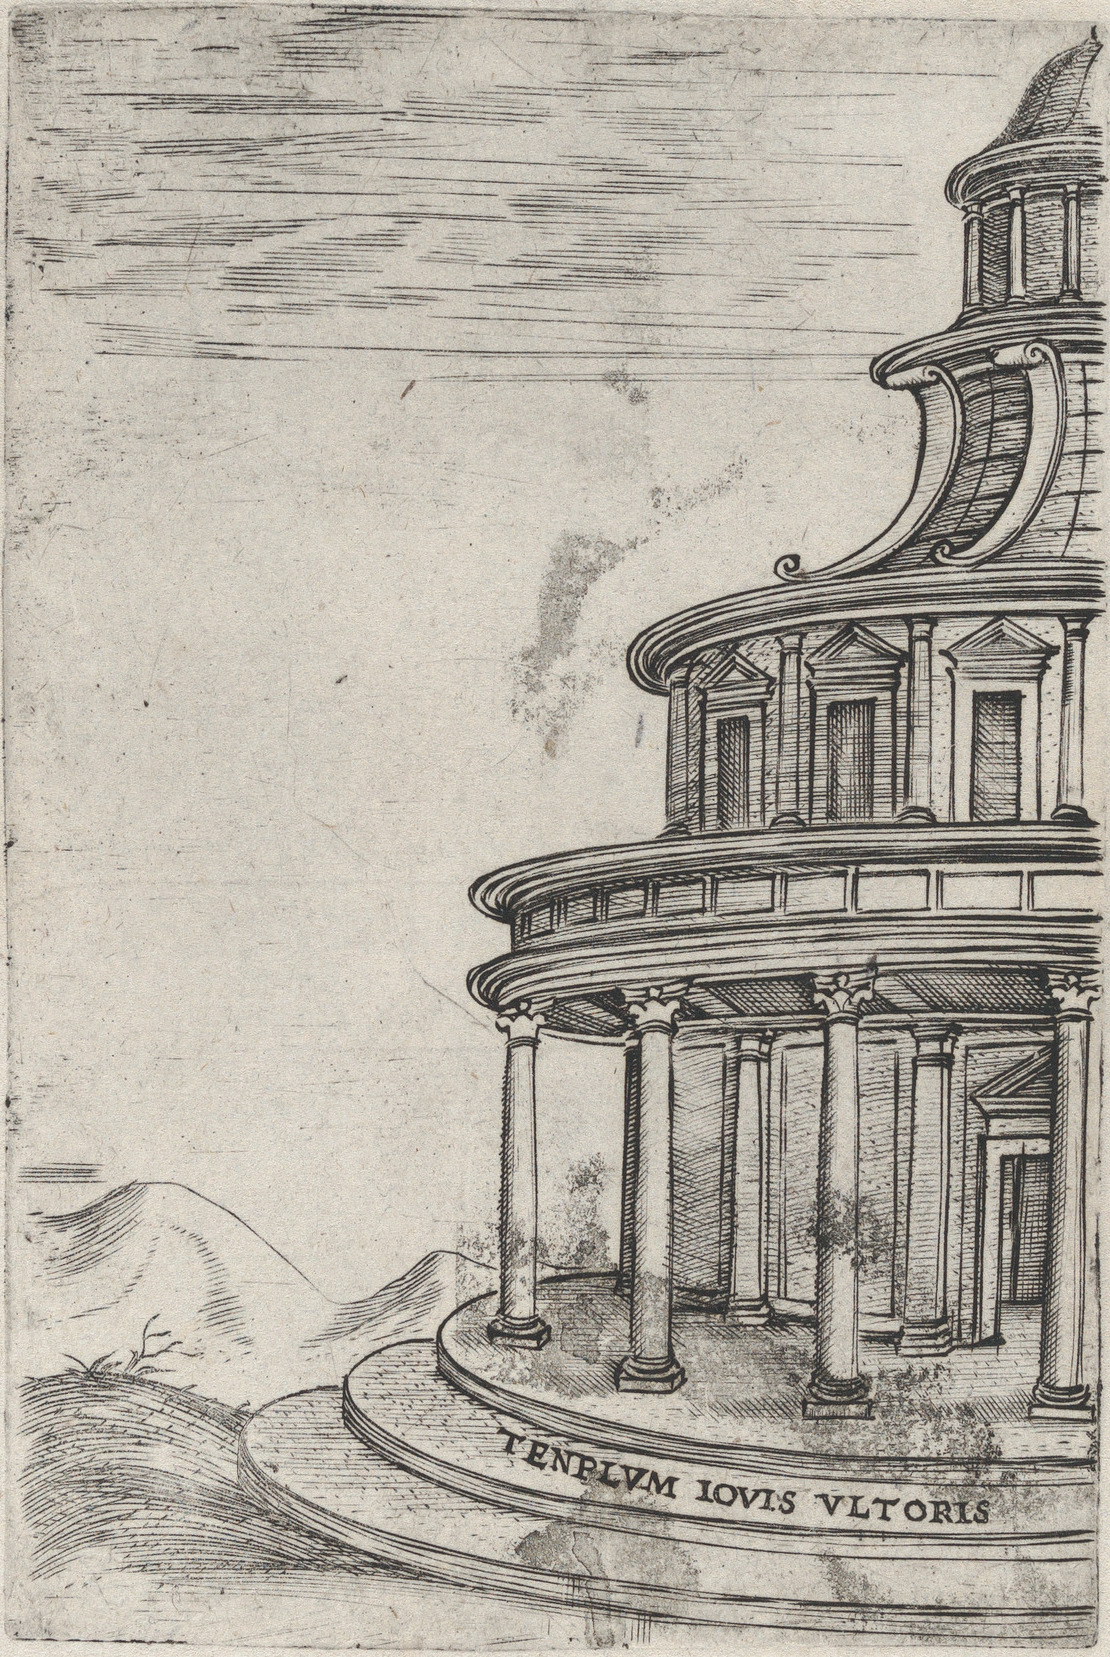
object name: print ornament architecture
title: Tenplum (sic) Iovis Ultoris, from a Series of 24 Depicting (Reconstructed) Buildings from Roman Antiquity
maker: anonymous, italian, 16th century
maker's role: artist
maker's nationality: italian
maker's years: 1500-1600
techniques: engraving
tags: architecture,buildings